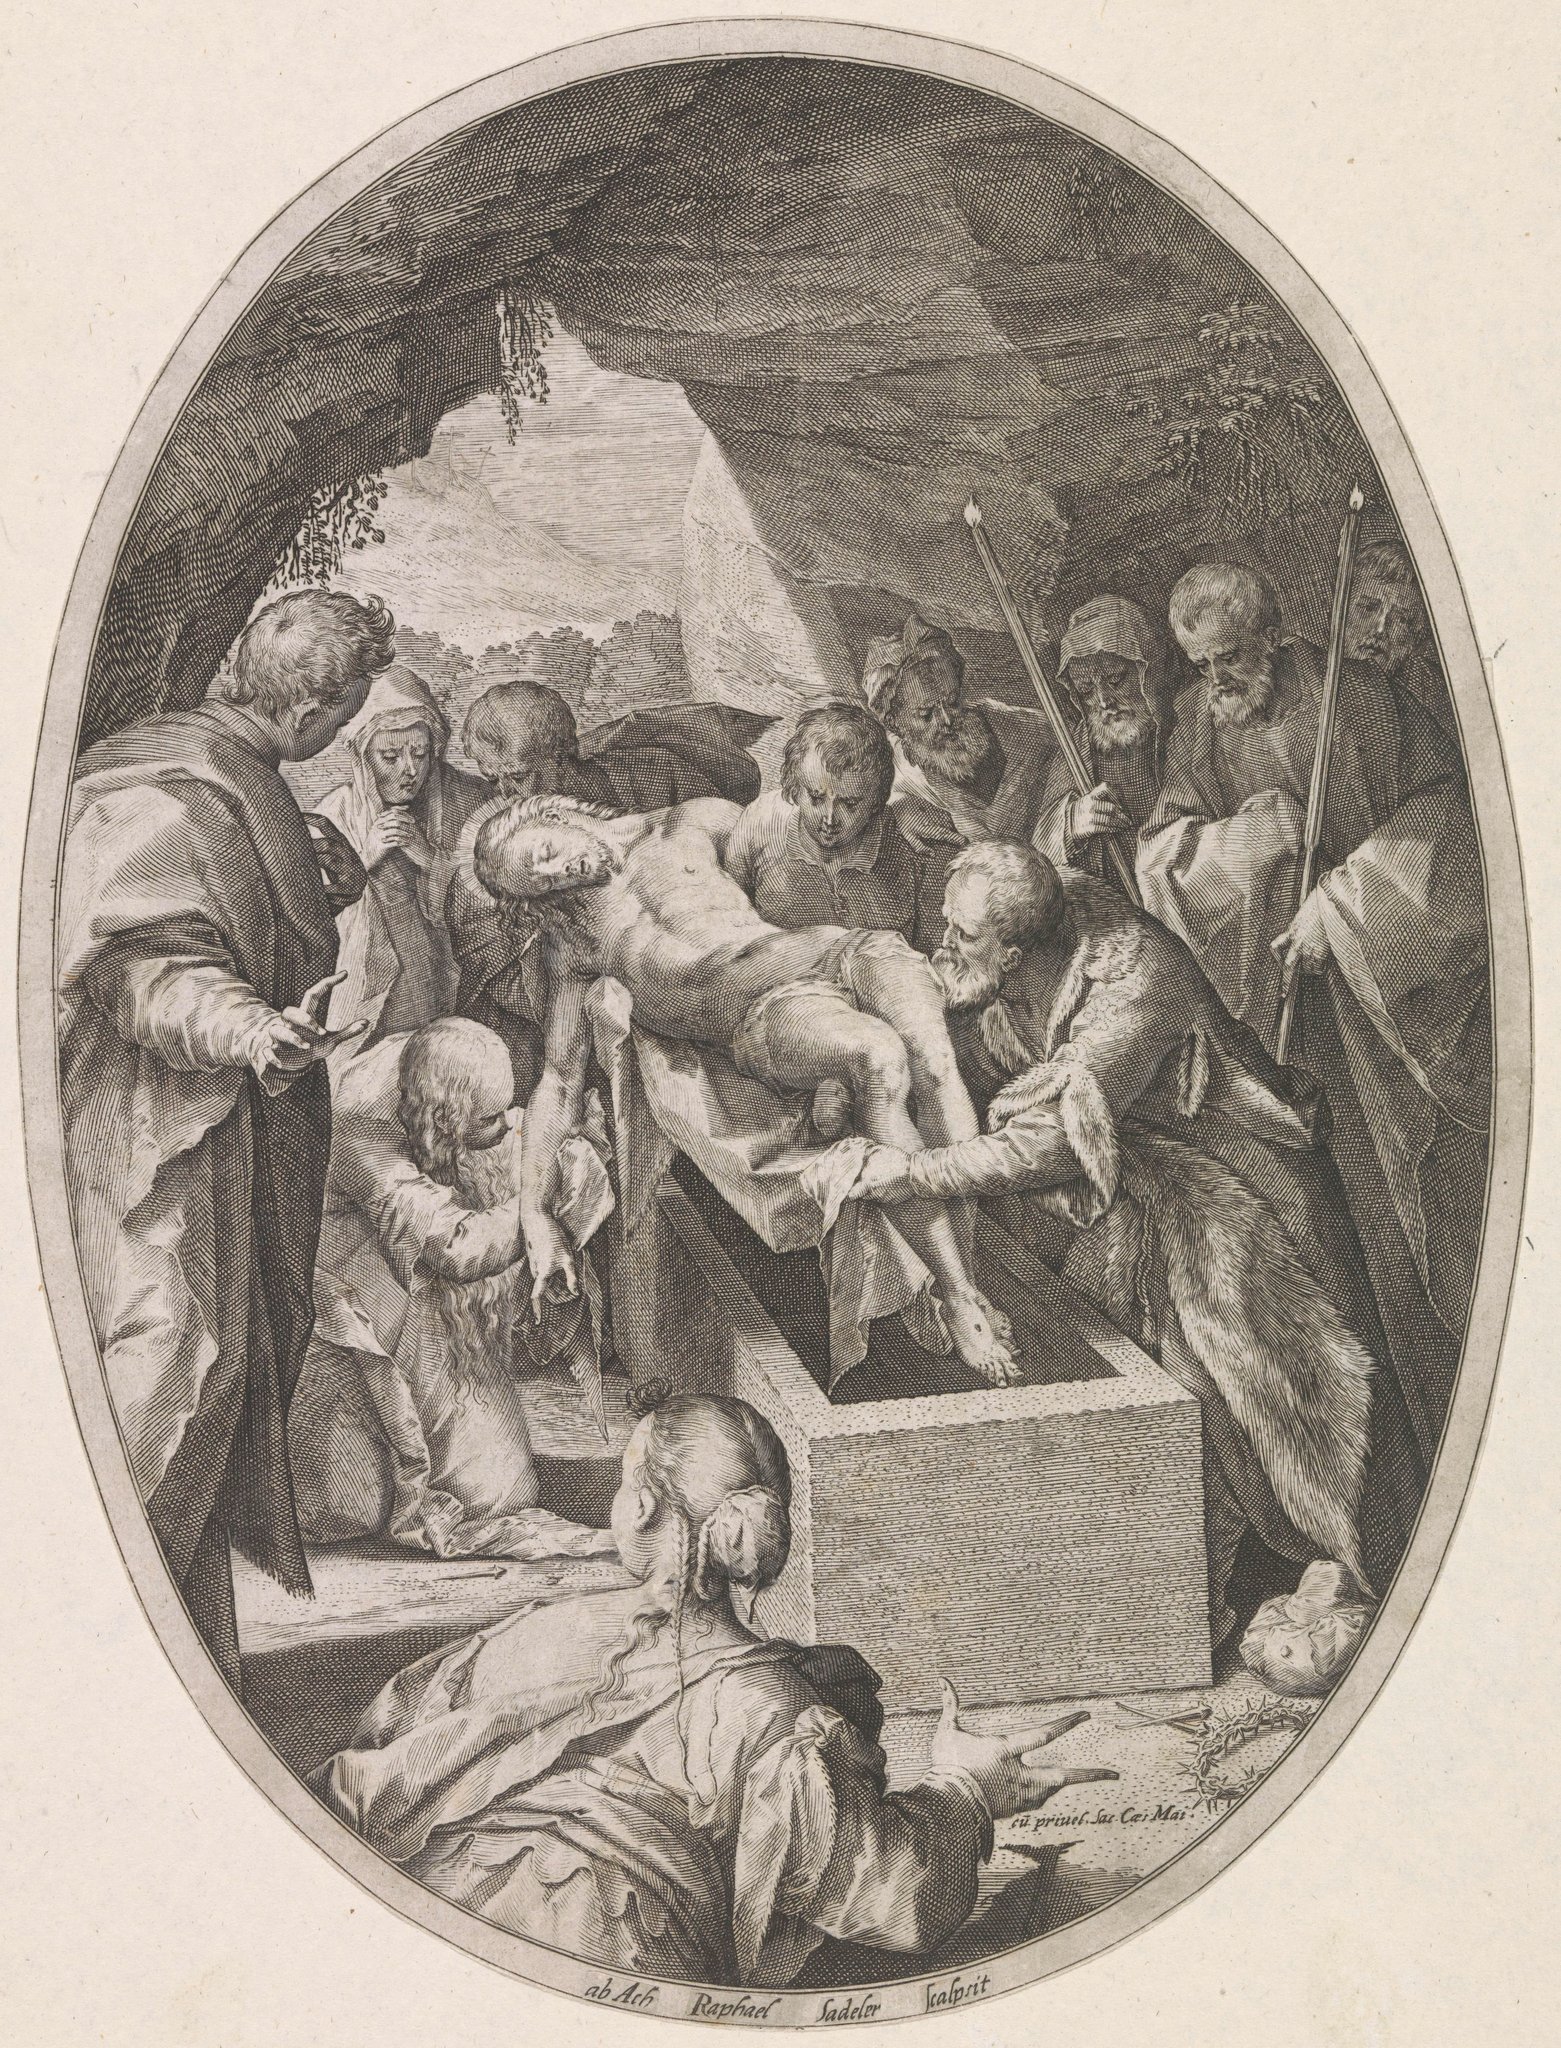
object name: print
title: Graflegging van Christus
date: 1593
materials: paper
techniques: engraving, etching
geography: munich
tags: christ's entombment (possibly by angels)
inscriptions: collector's mark: Lugt 2228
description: In een grot wordt Christus door zijn familie, leerlingen en vrienden in een graftombe gelegd.